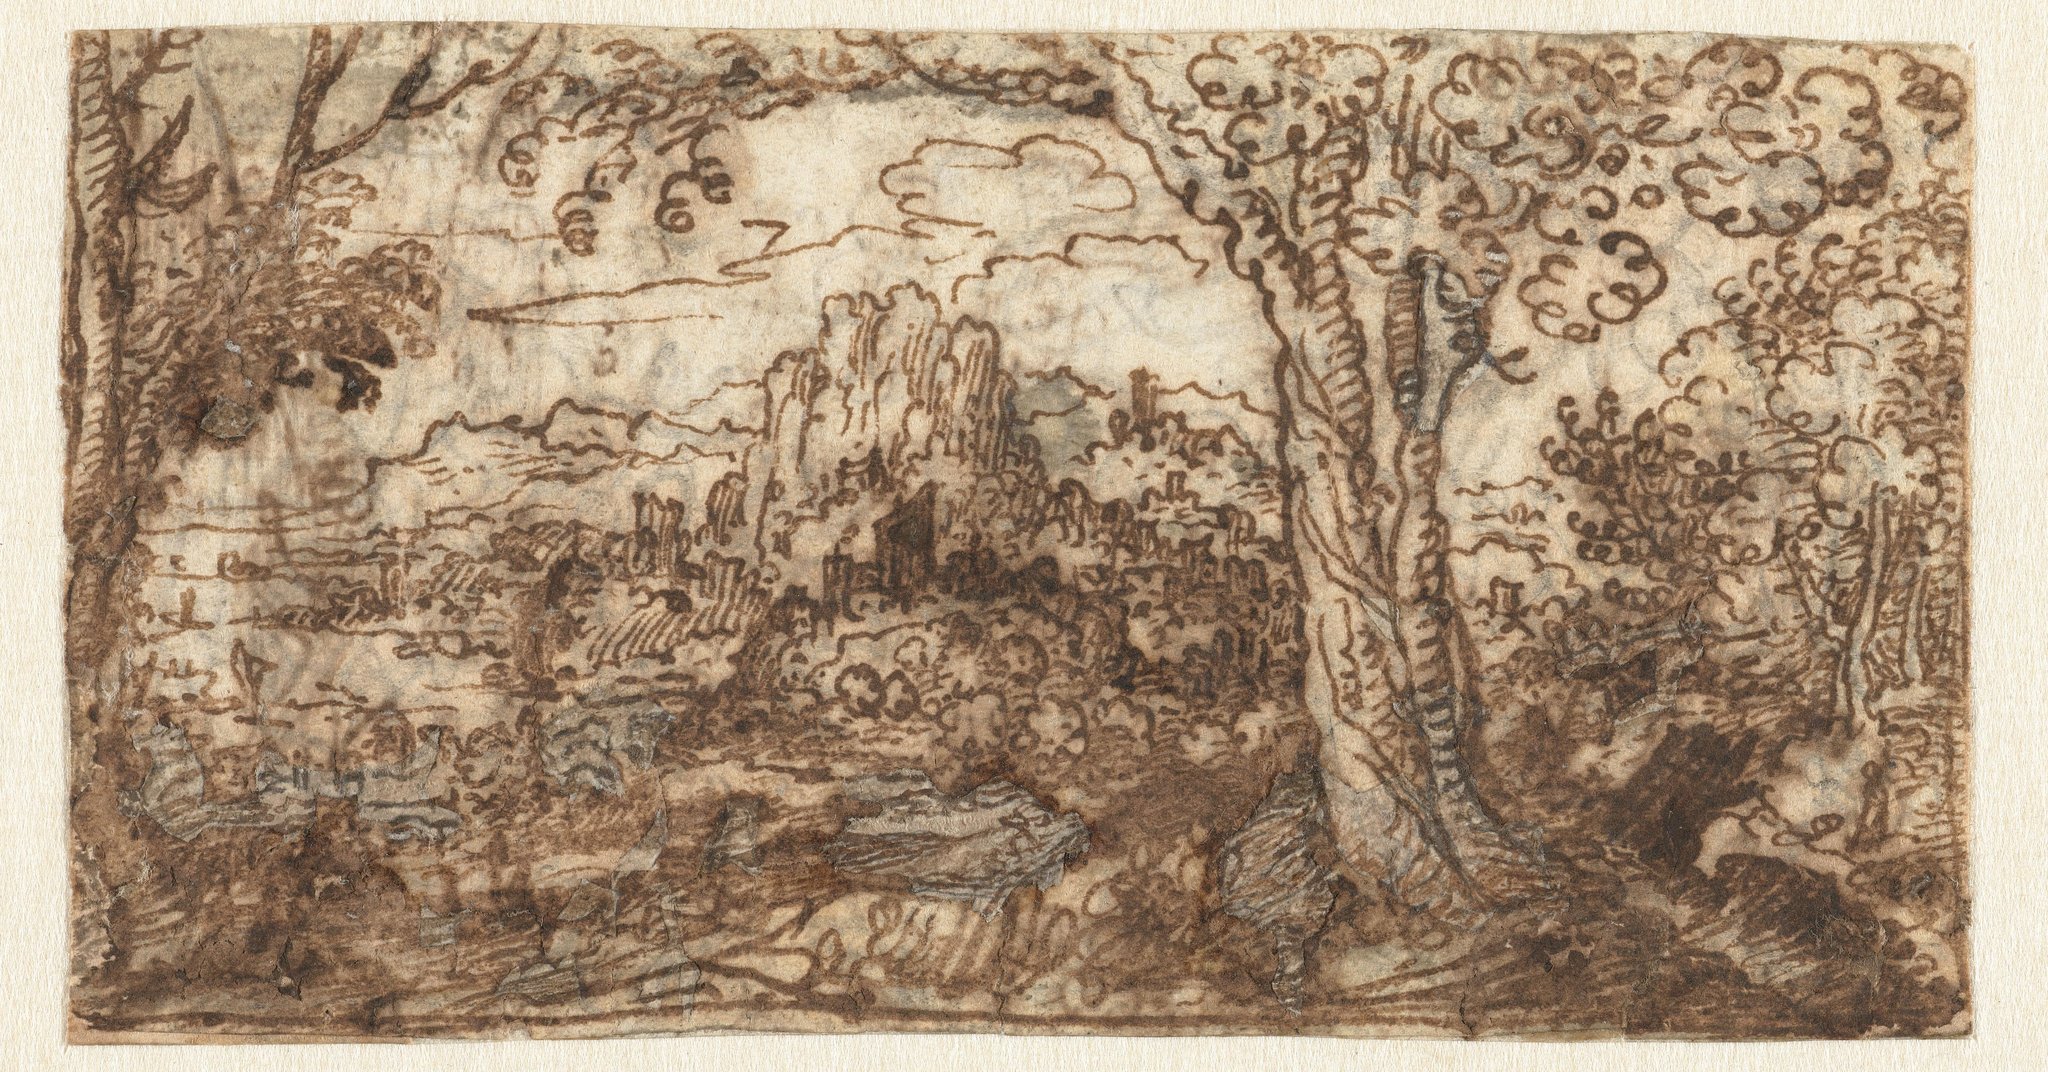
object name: drawing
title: Gezicht over een berglandschap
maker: cigoli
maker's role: draughtsman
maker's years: 1559-1613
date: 1570-1613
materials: graphite, ink, paper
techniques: pen